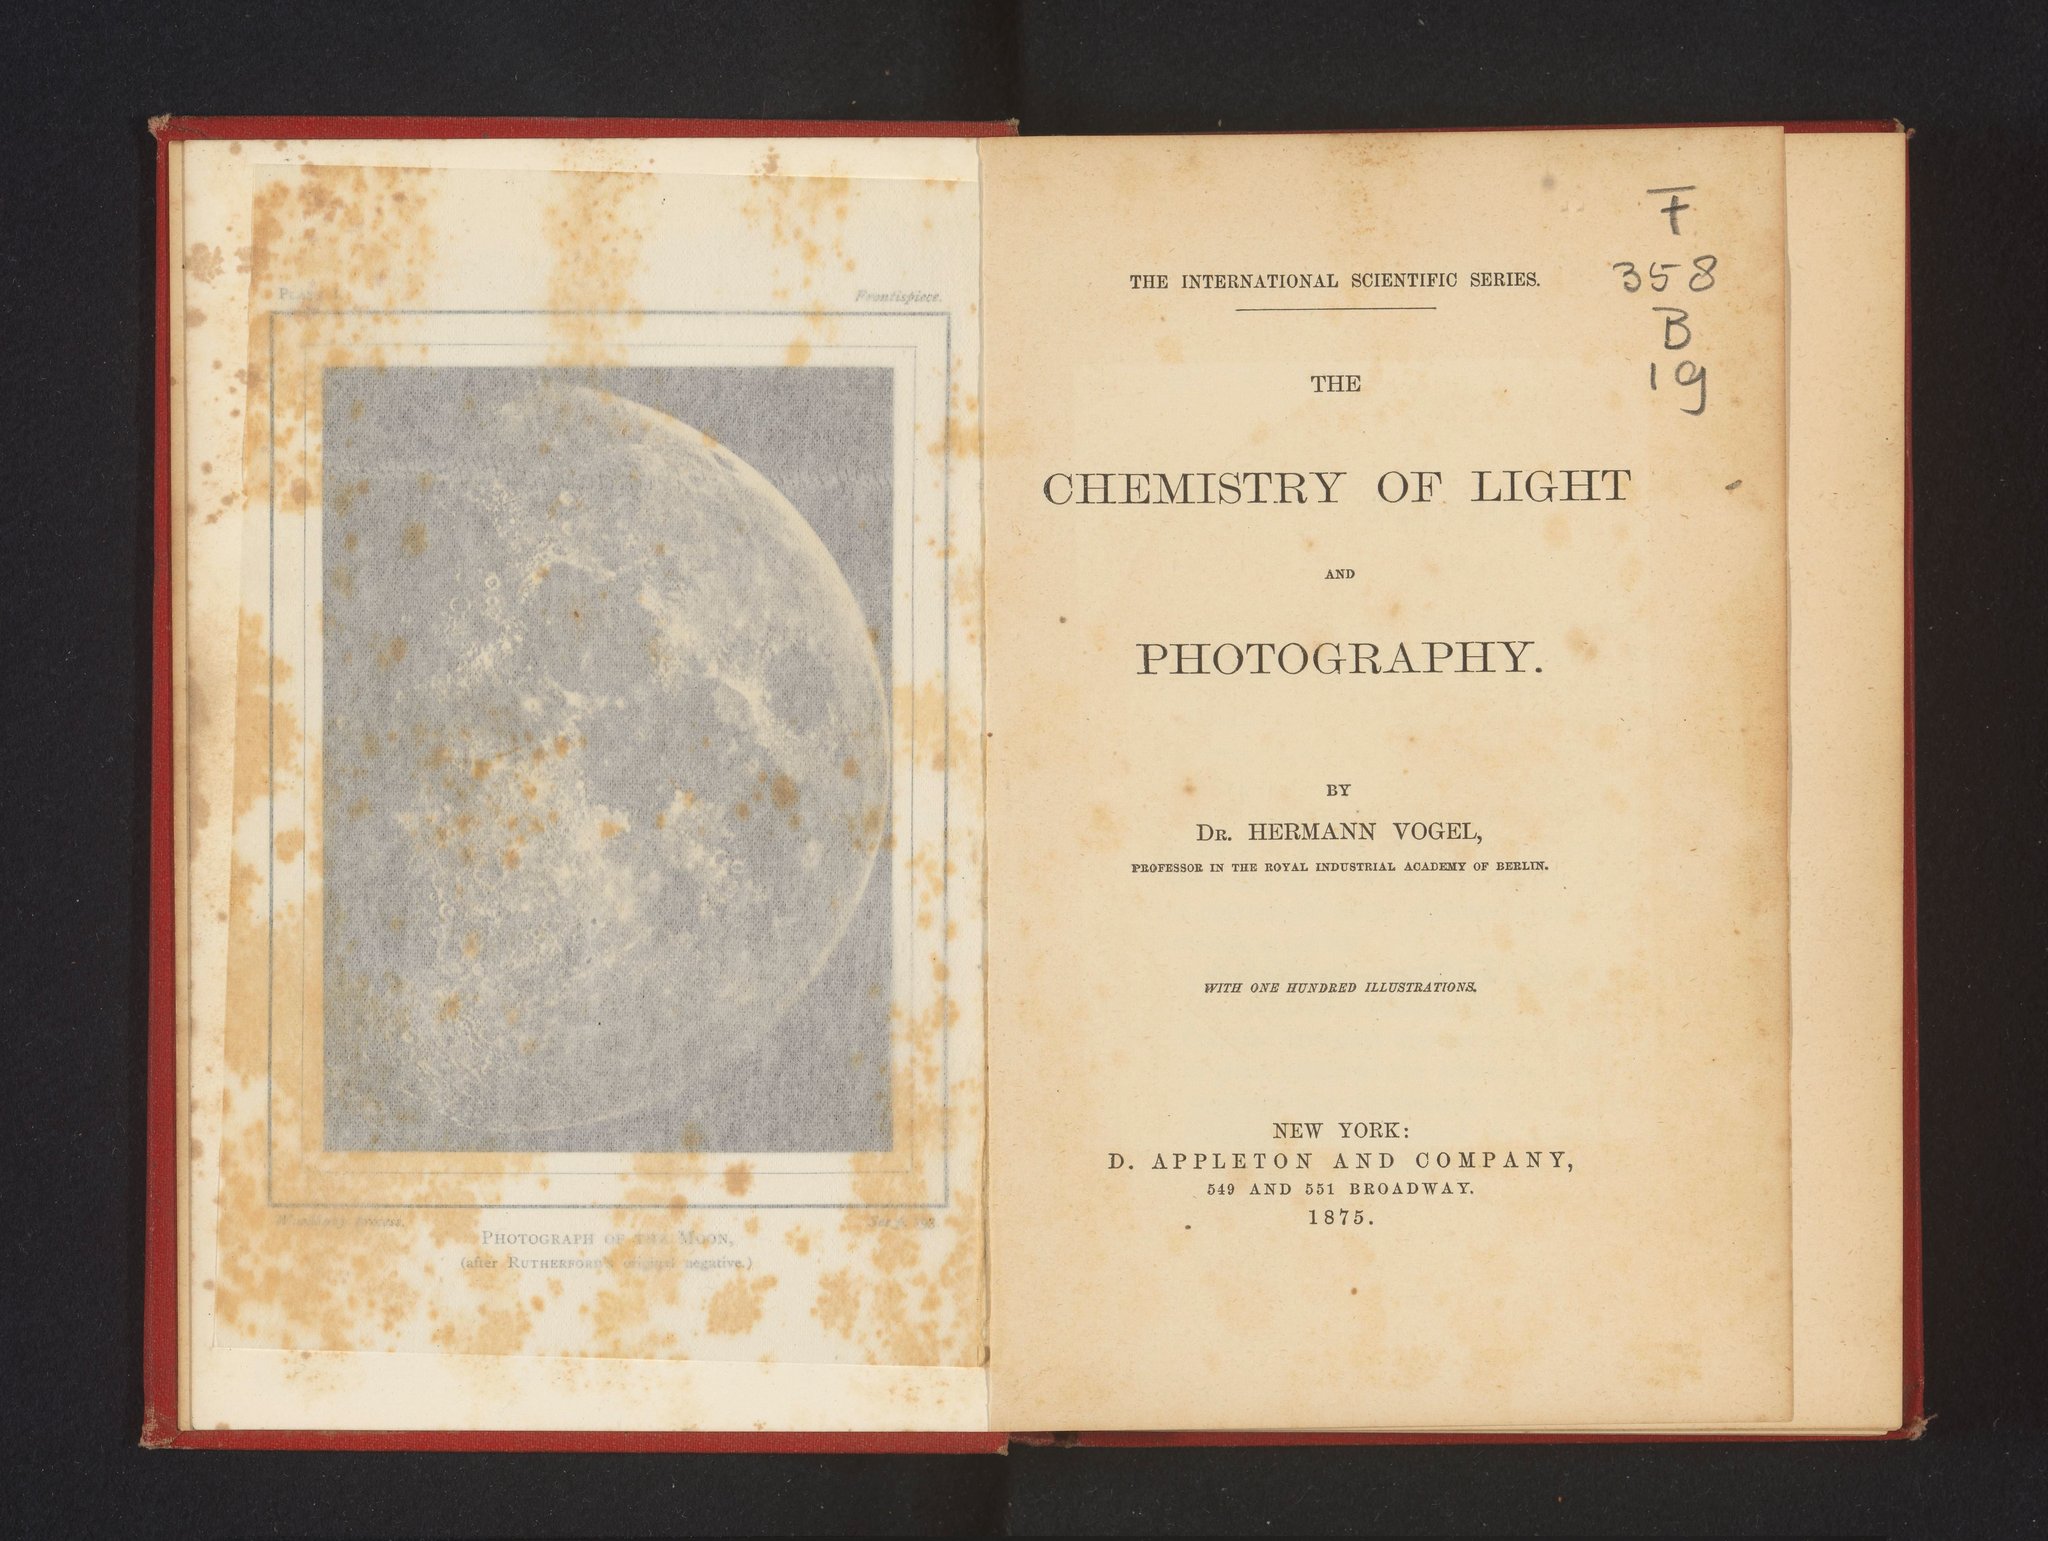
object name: book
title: The chemistry of light and photography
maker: hermann wilhelm vogel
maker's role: chemicus, fotograaf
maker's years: 1834-1898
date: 1875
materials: cardboard, paper, textile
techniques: photograph, photoaquatint, printing, engraving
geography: new york city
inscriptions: bookplate: ‘SFJ ex libris’, annotation: ‘FEB 1982’